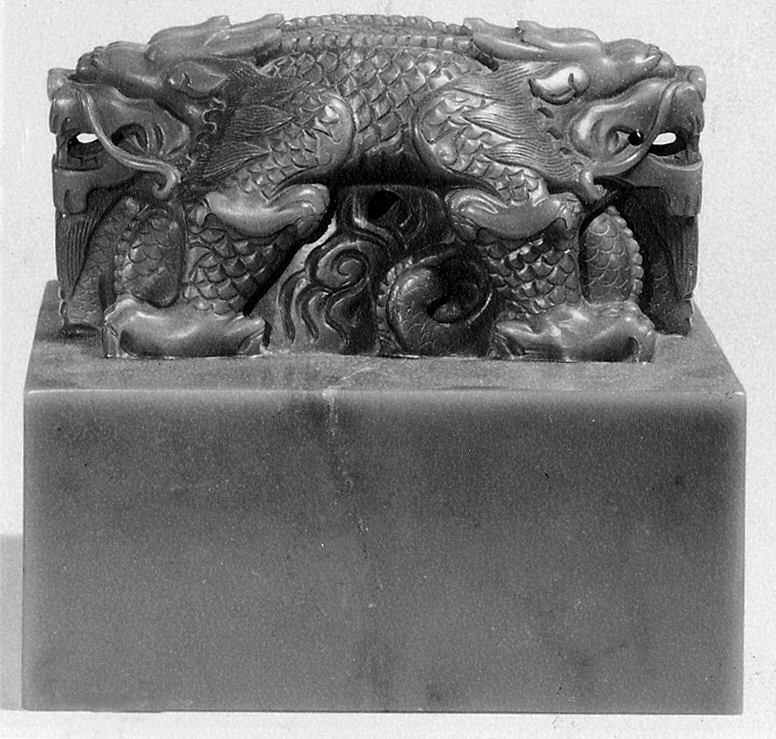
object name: seal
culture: chinese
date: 1801-1900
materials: jade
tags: dragons